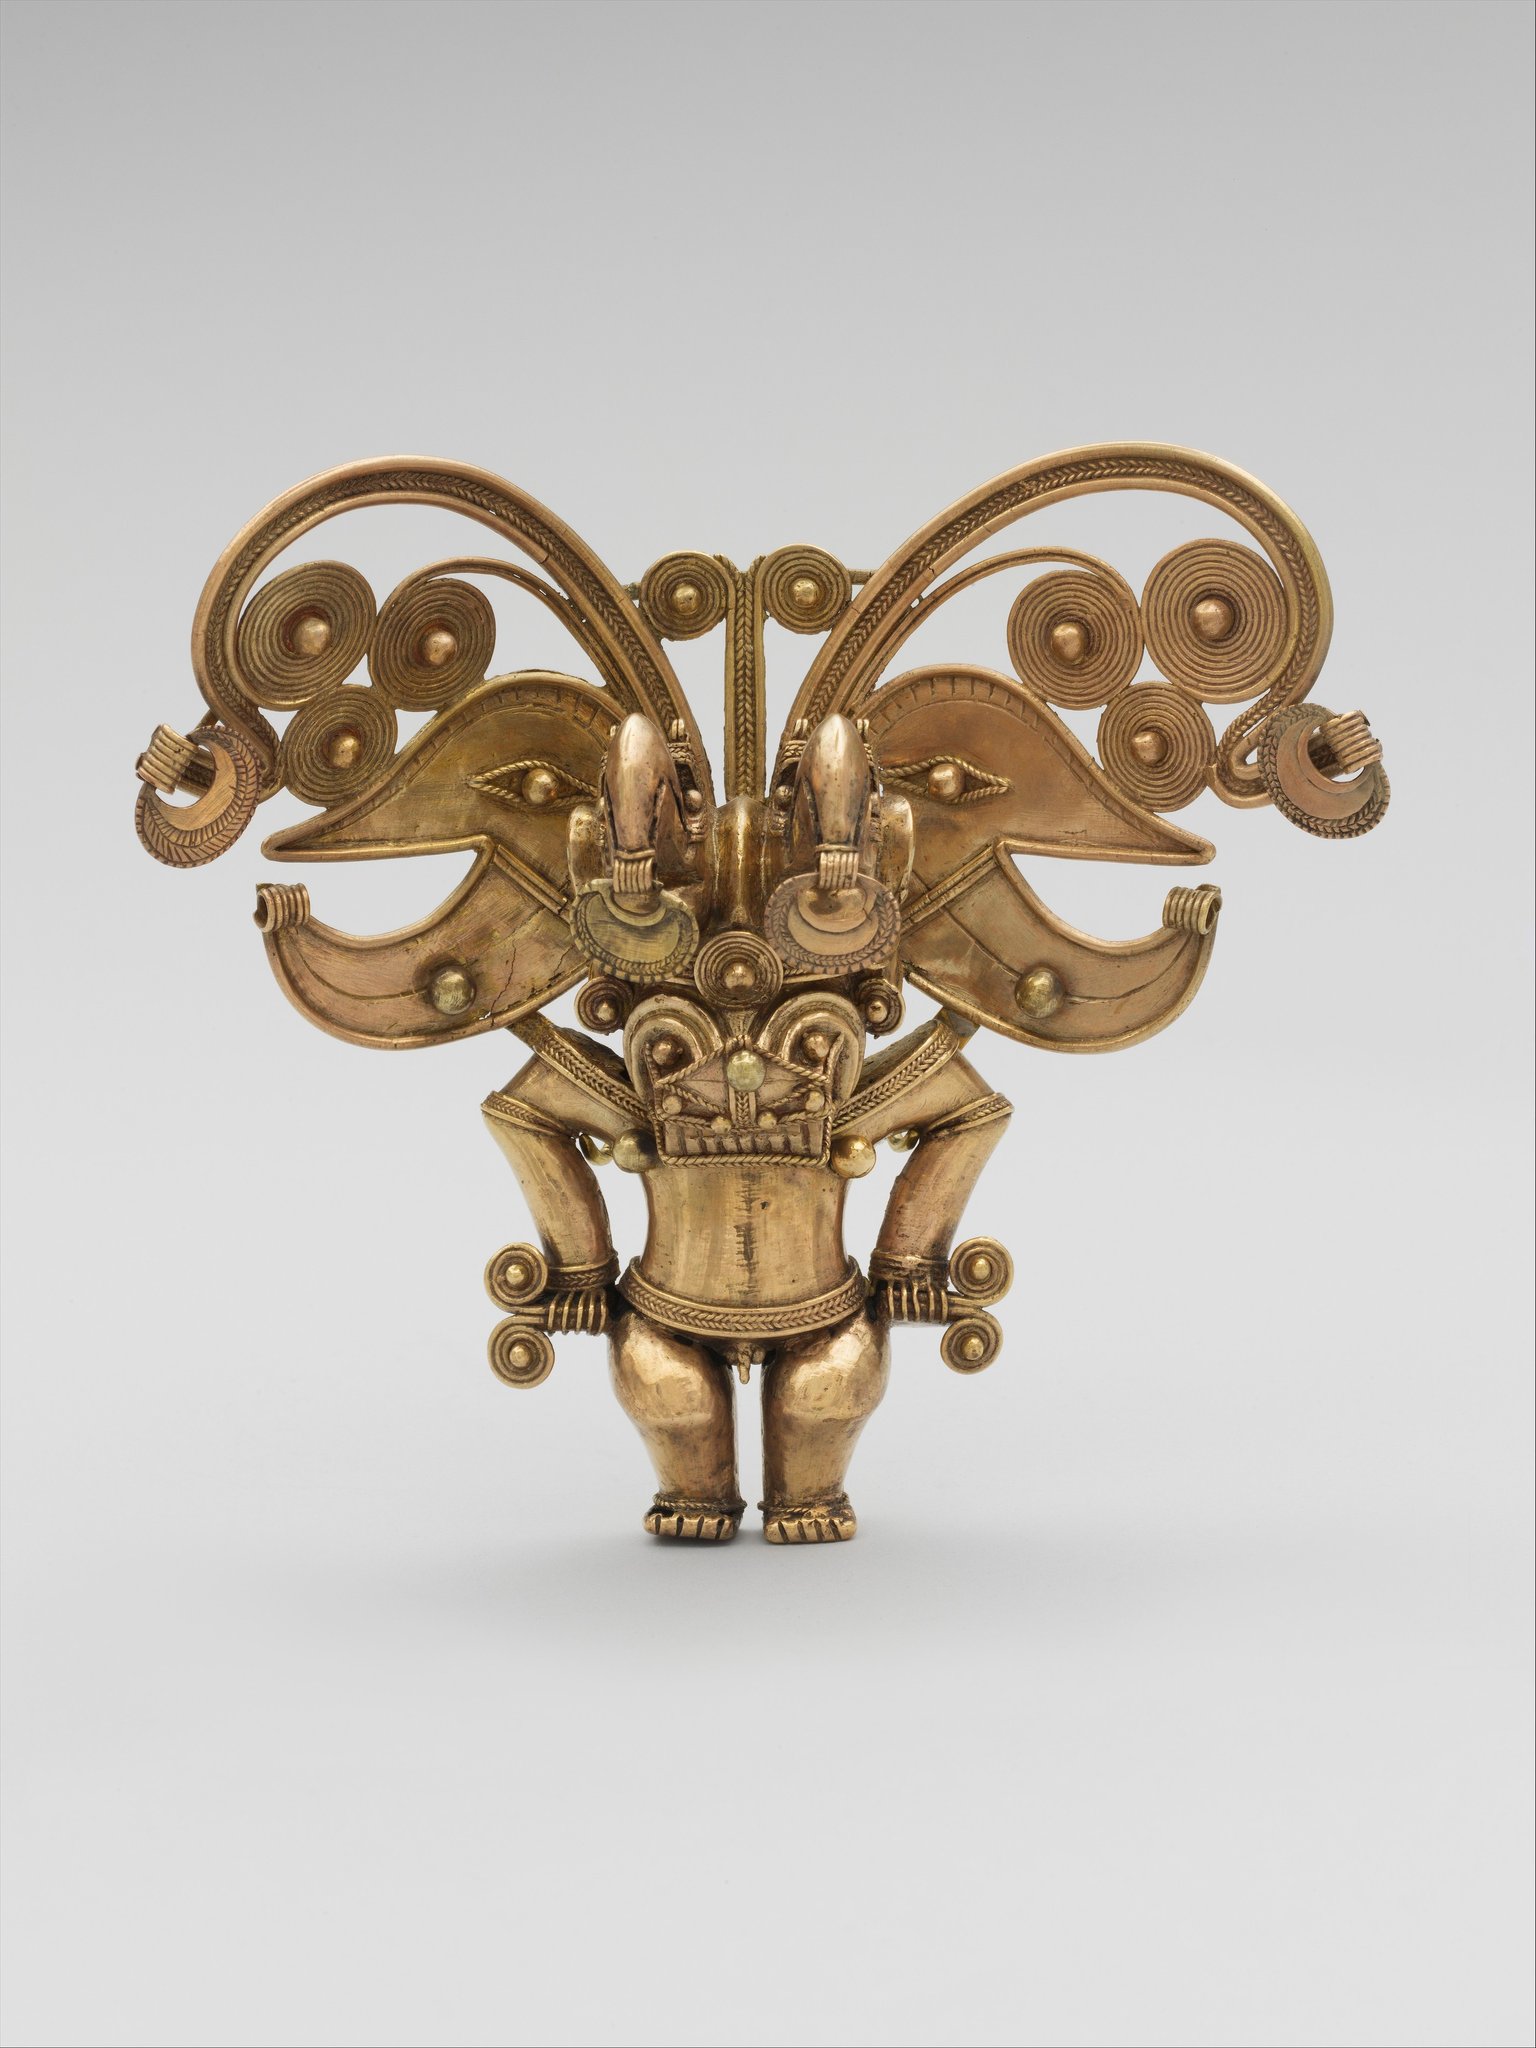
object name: pendant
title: Masked-figure pendant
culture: tairona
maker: tairona artist(s)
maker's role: artist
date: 900-1600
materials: gold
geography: colombia